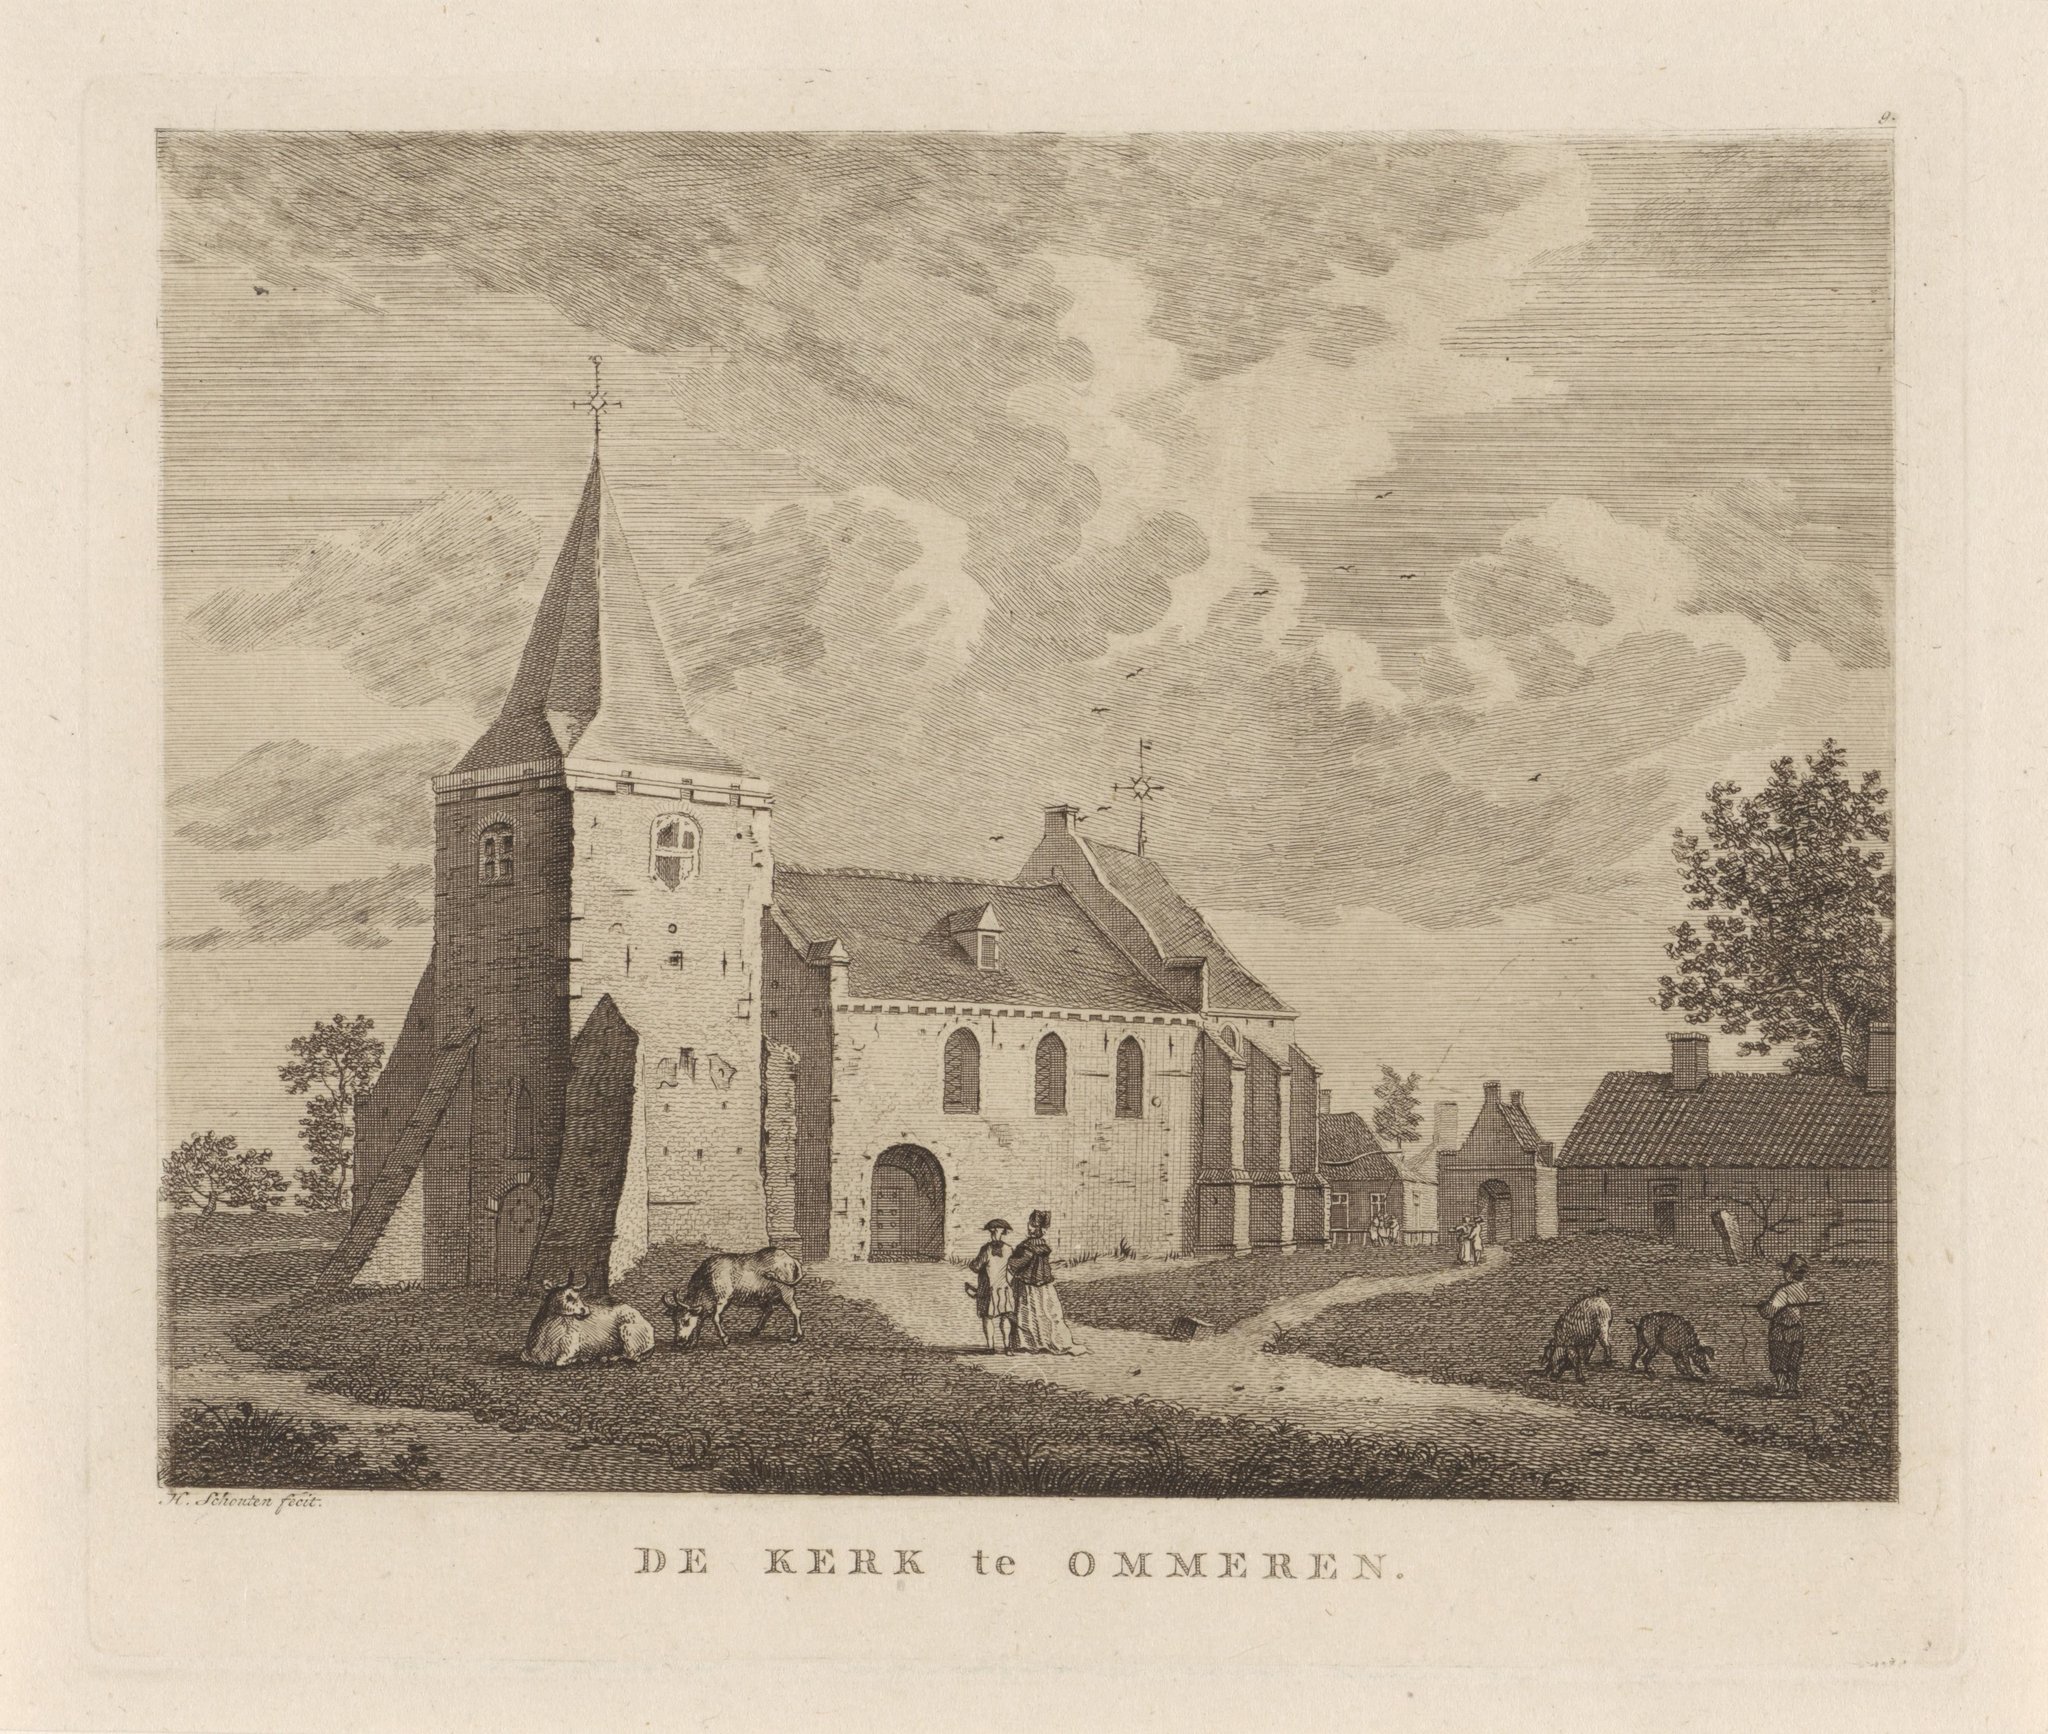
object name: print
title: De kerk te Ommeren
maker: hermanus petrus schouten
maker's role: draughtsman, painter, print maker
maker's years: 1747-1822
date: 1762-1822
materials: paper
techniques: etching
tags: church (exterior) - qq - small church, chapel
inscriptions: collector's mark: Lugt 2228